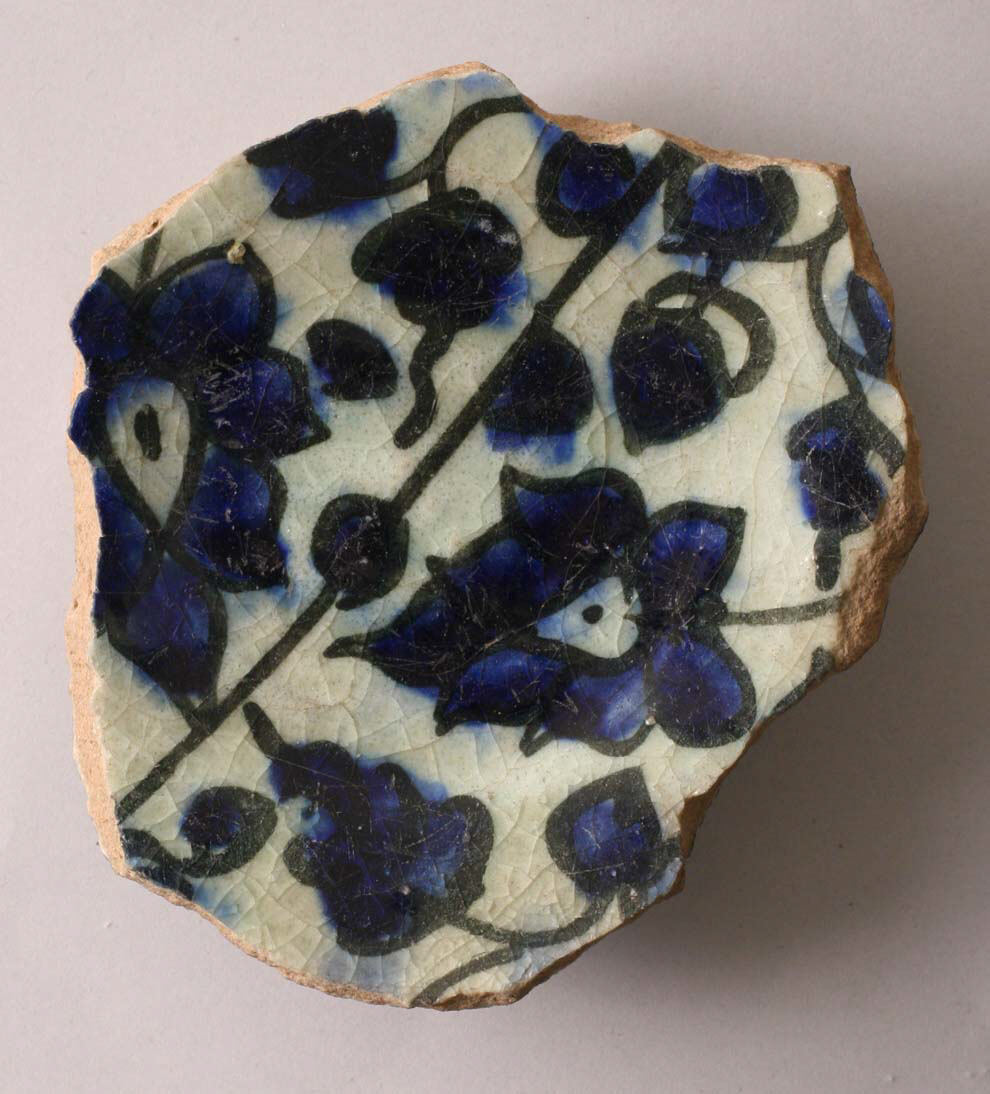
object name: ceramic fragment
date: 1301-1500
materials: glaze, stonepaste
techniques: painting, polychrome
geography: egypt